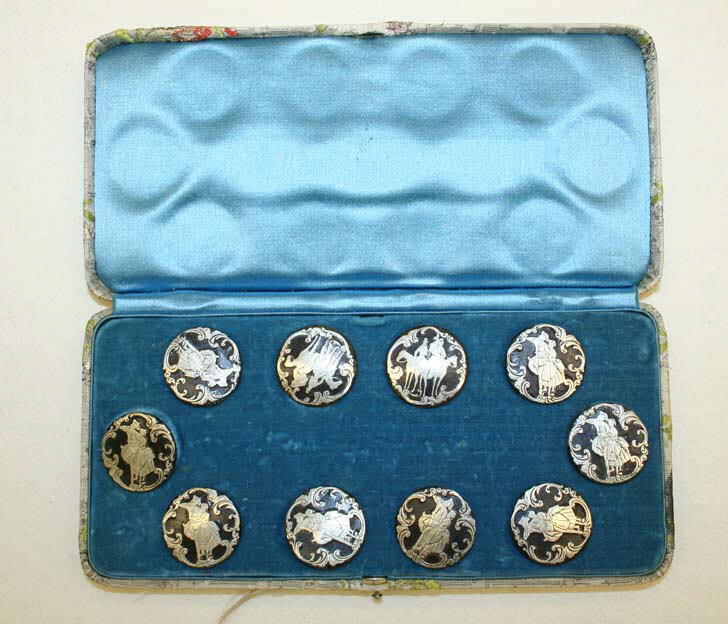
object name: button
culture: french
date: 1780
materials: horn, silver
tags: human figures